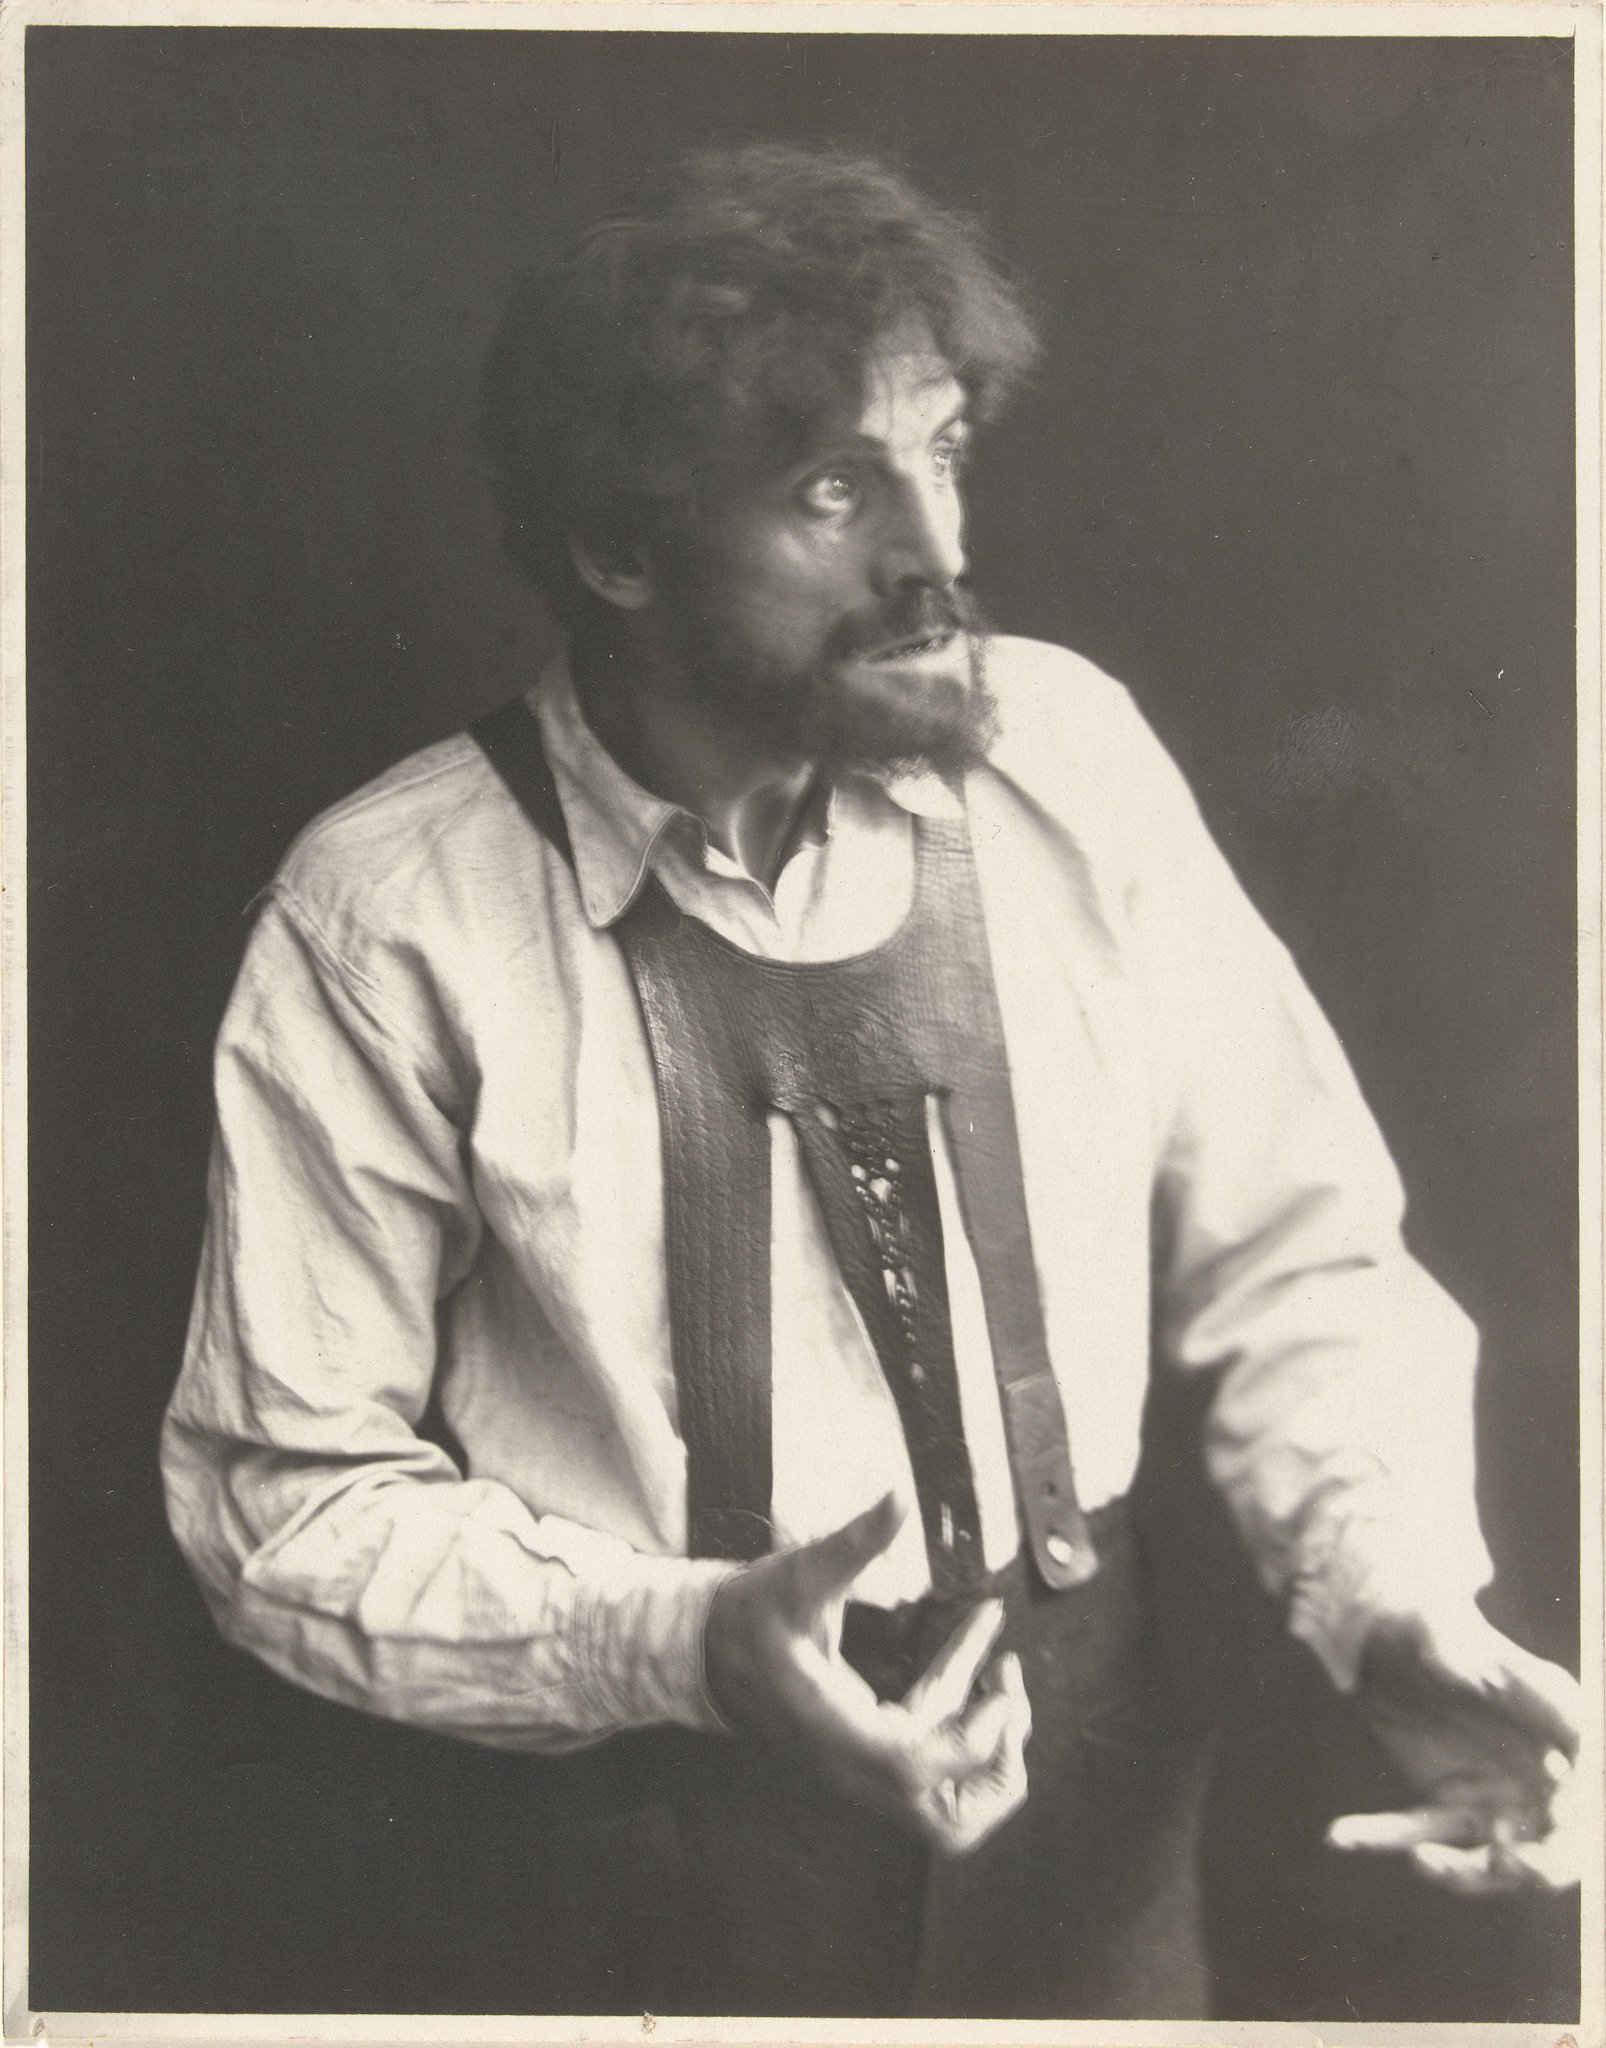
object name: photograph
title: Portret van een acteur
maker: Anonymous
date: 1900-1960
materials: photographic support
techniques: gelatin silver print